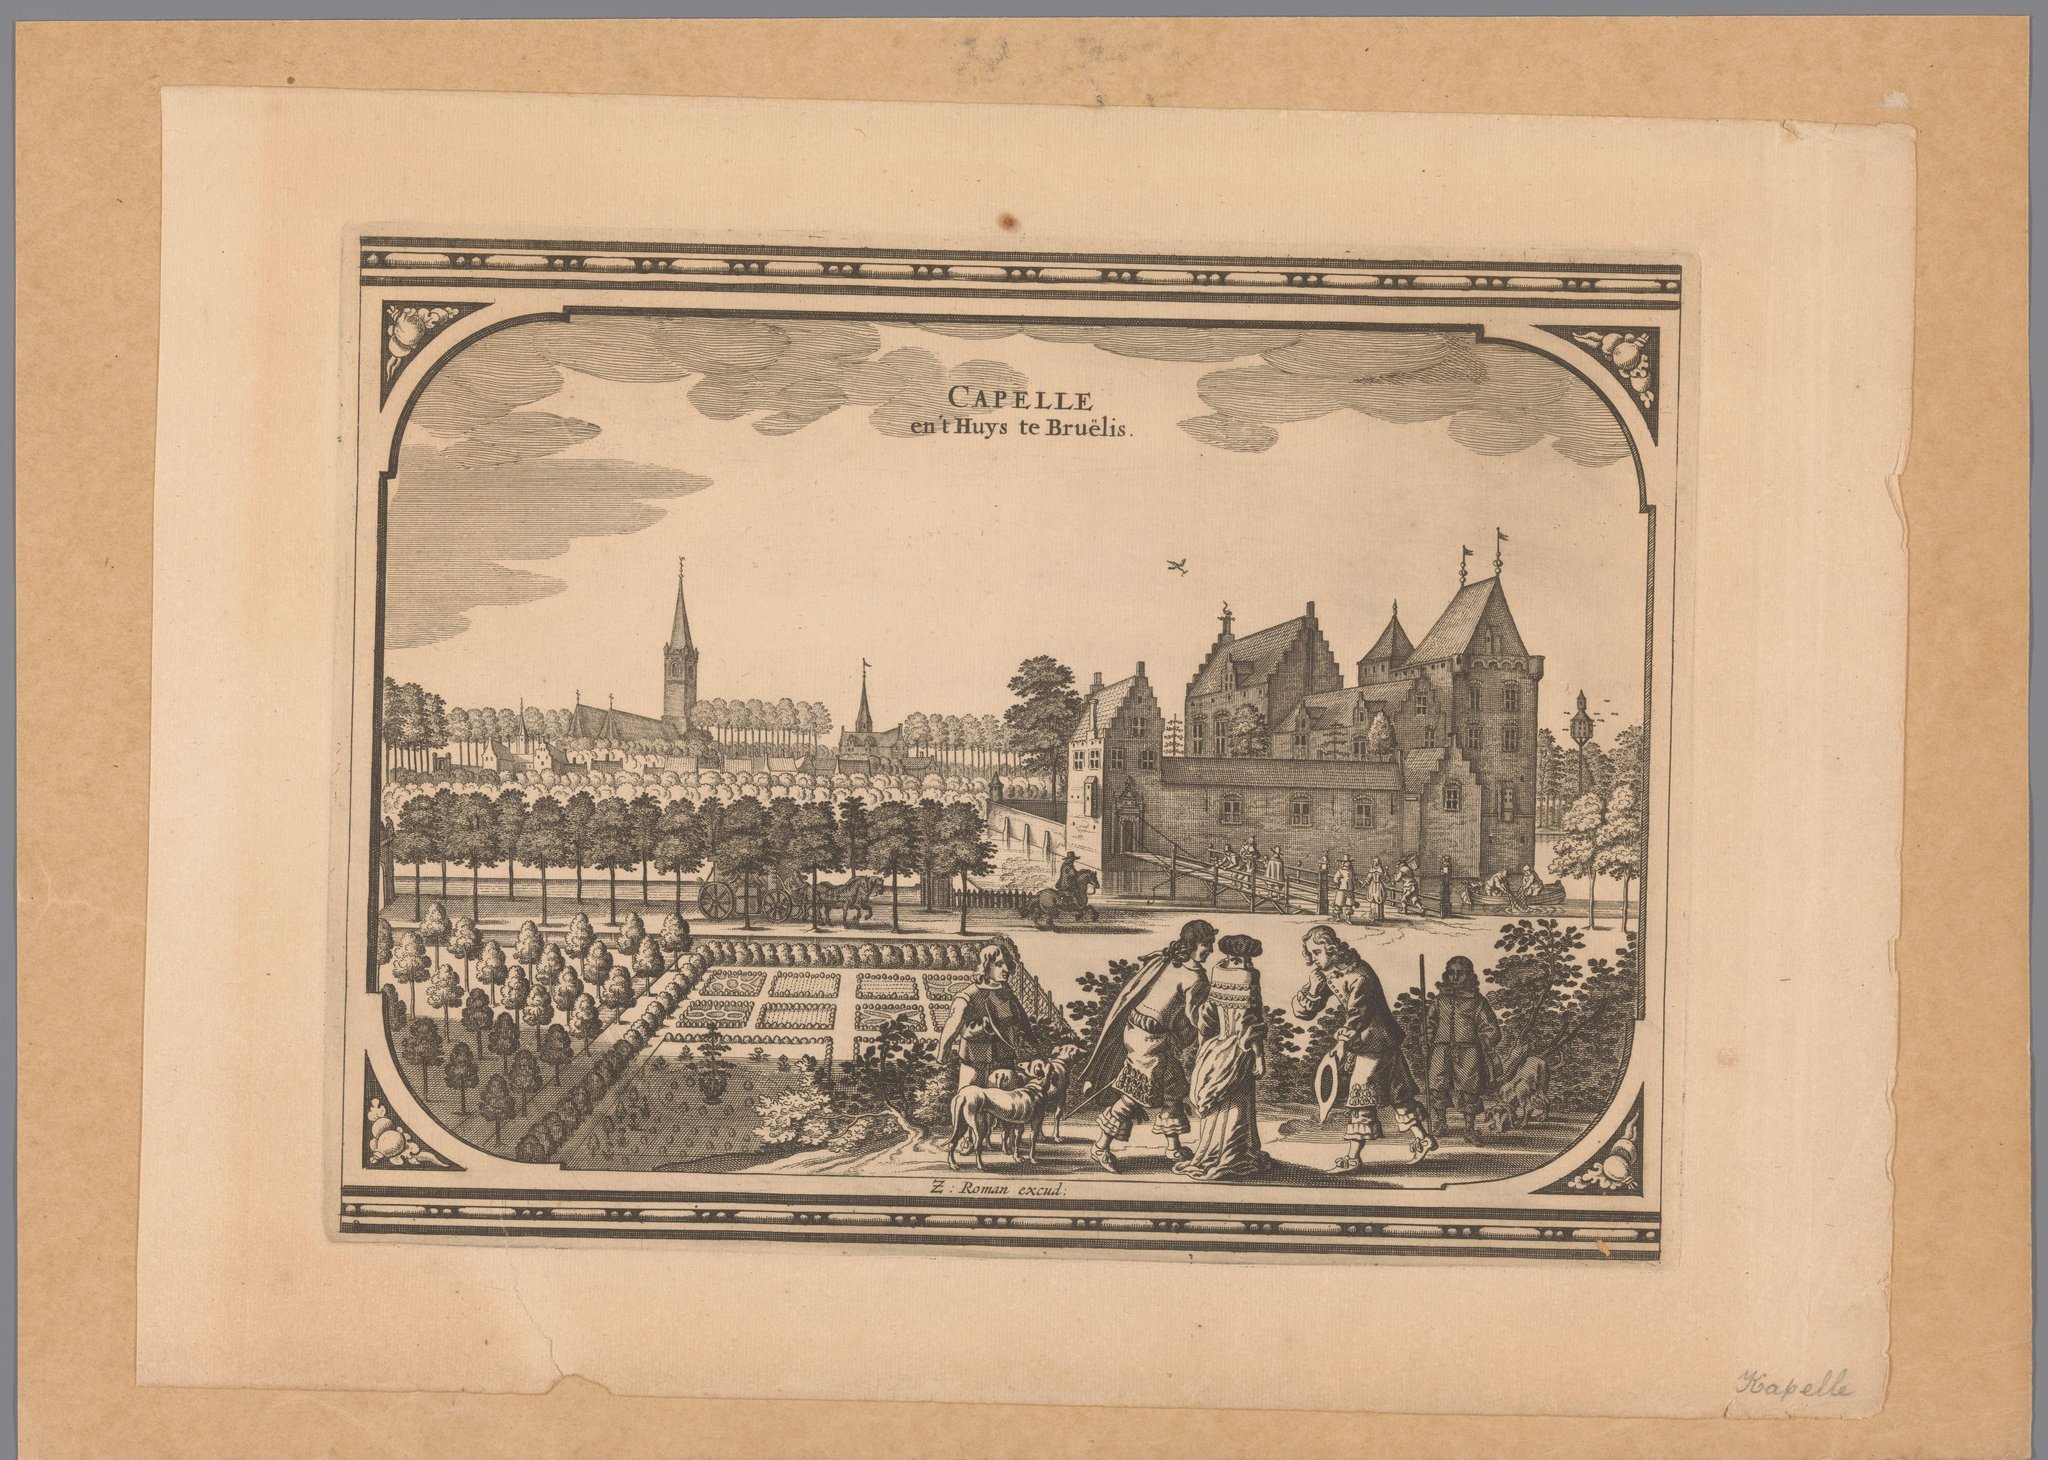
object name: print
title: Gezicht op Kapelle en Kasteel Bruëlis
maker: pieter hendricksz. schut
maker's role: print maker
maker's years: 1618-1660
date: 1657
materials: paper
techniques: engraving, etching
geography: amsterdam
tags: prospect of village, silhouette of village, castle, church (exterior)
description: Prent uit: Theatrum praecipuarum urbium ducatus Brabantiae nec non comitatuum Flandriae et Zelandiae. Amsterdam: Nicolaes Visscher (I), 1657. Verwarring rondom de datering kan ontstaan door het feit dat de prenten die voorkomen in de bovengenoemde publicaties ook voorkomen in een eerder uitgegeven publicatie, waar ze later in zijn ingebonden (Boxhorn, Marcus Zuerius van. Chroniick van Zeelandt (…). 2 dln. Middelburg: Zacharias Roman, 1644).